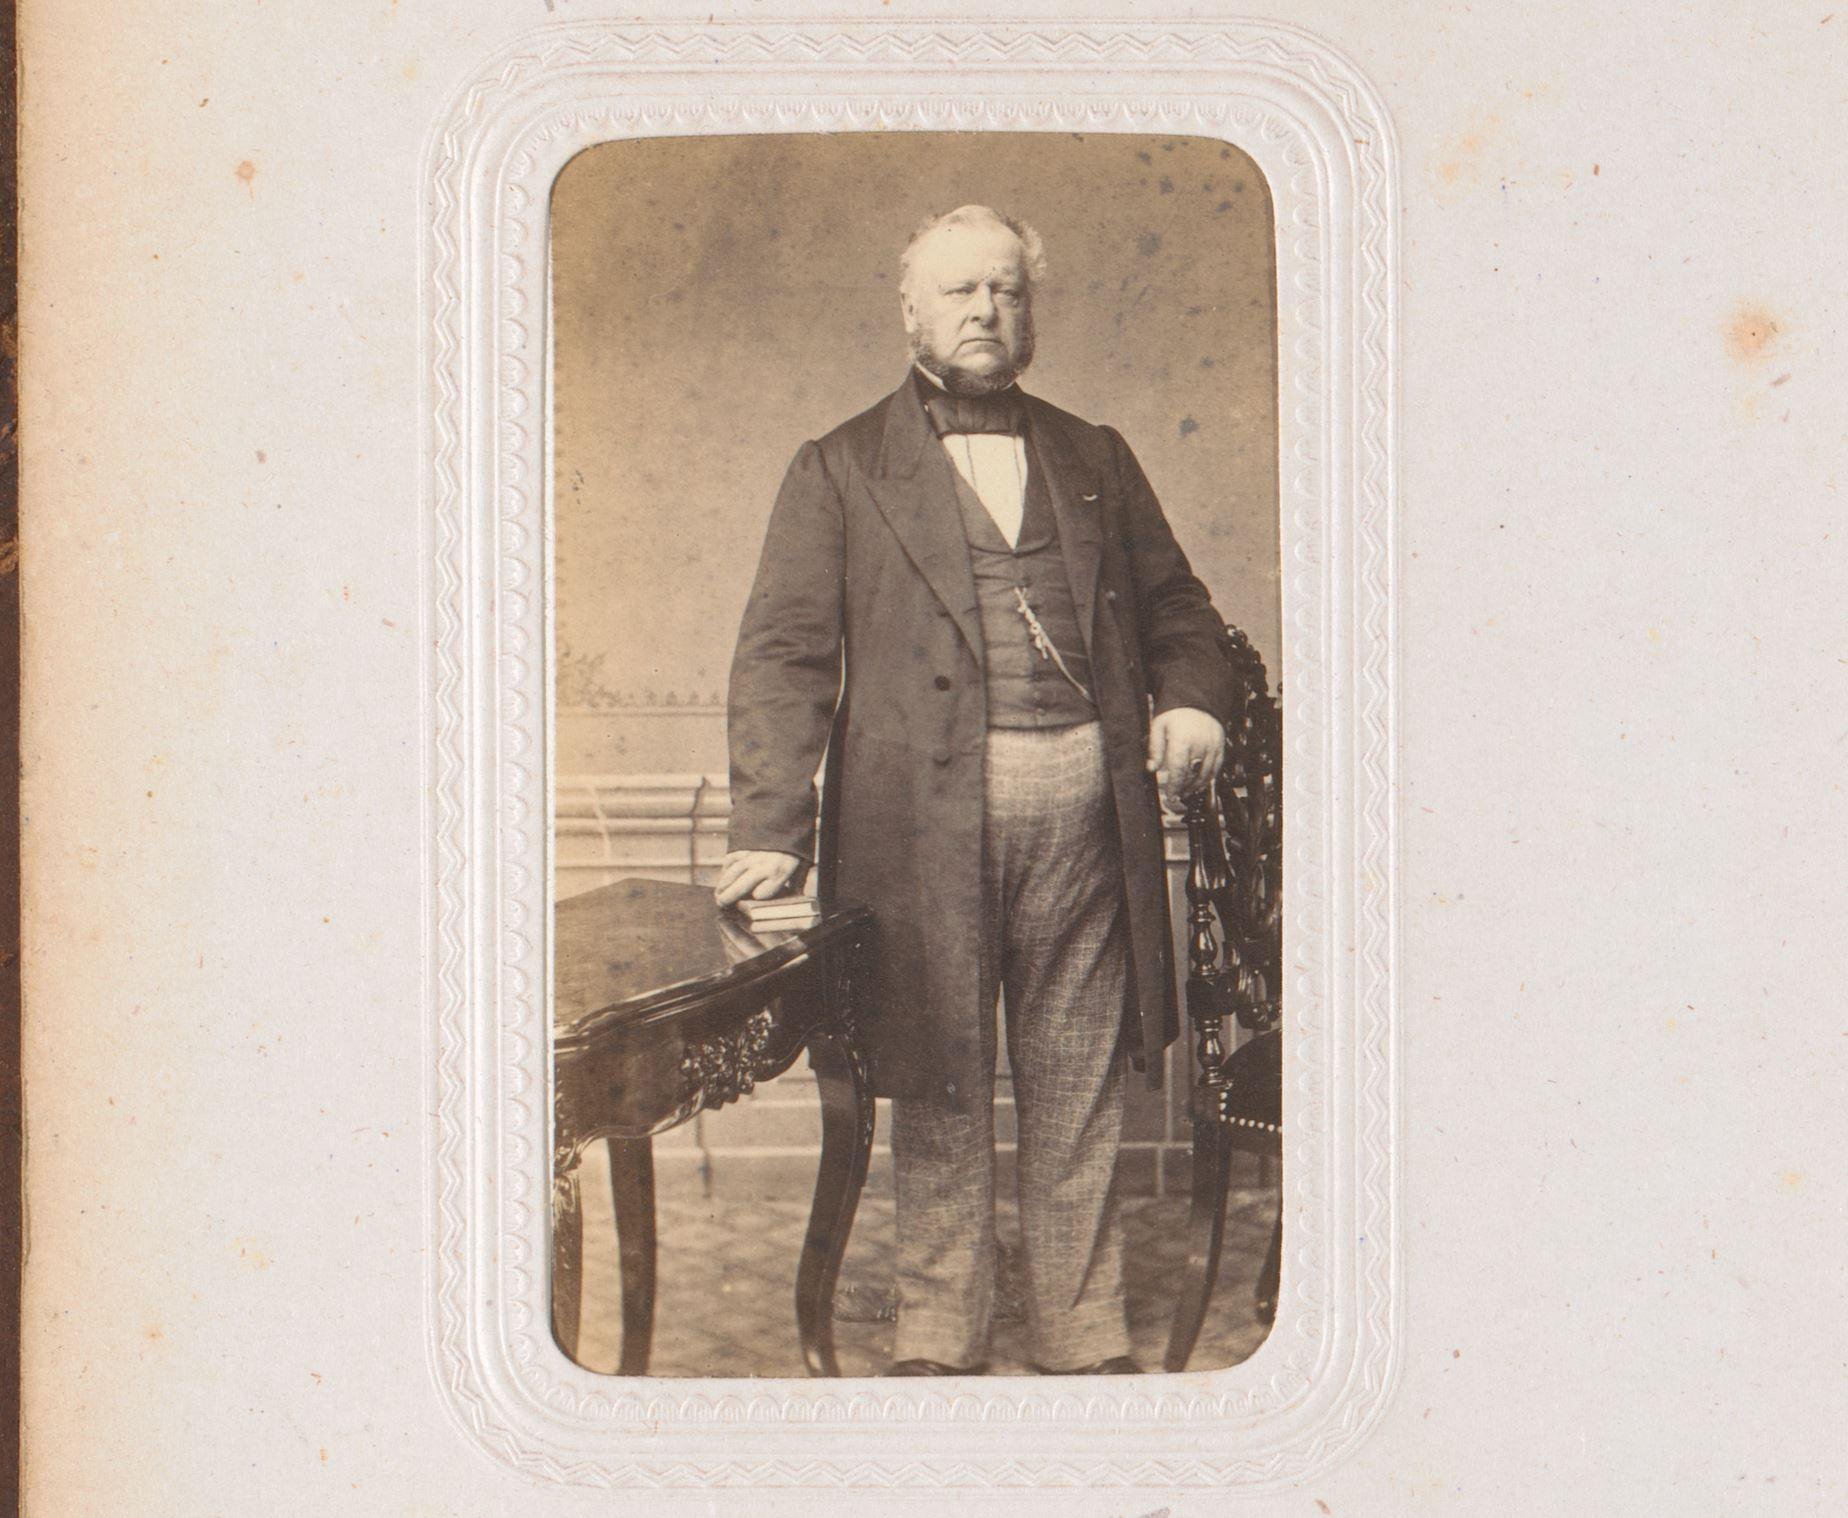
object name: album leaf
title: Portret van Tjaard Anne Marius Albert van Andringa de Kempenaer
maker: eduard fuchs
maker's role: painter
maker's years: 1832-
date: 1859-1870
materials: cardboard, photographic support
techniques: albumen print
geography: leeuwarden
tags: historical persons, politician, e.g. party leader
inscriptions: inscription: ‘PHOTOGRAPHIE/ E. FUCHS/ LEEUWARDEN.’, name: ‘Andringa de Kempenaer’, name: ‘[...]Kempenaer’